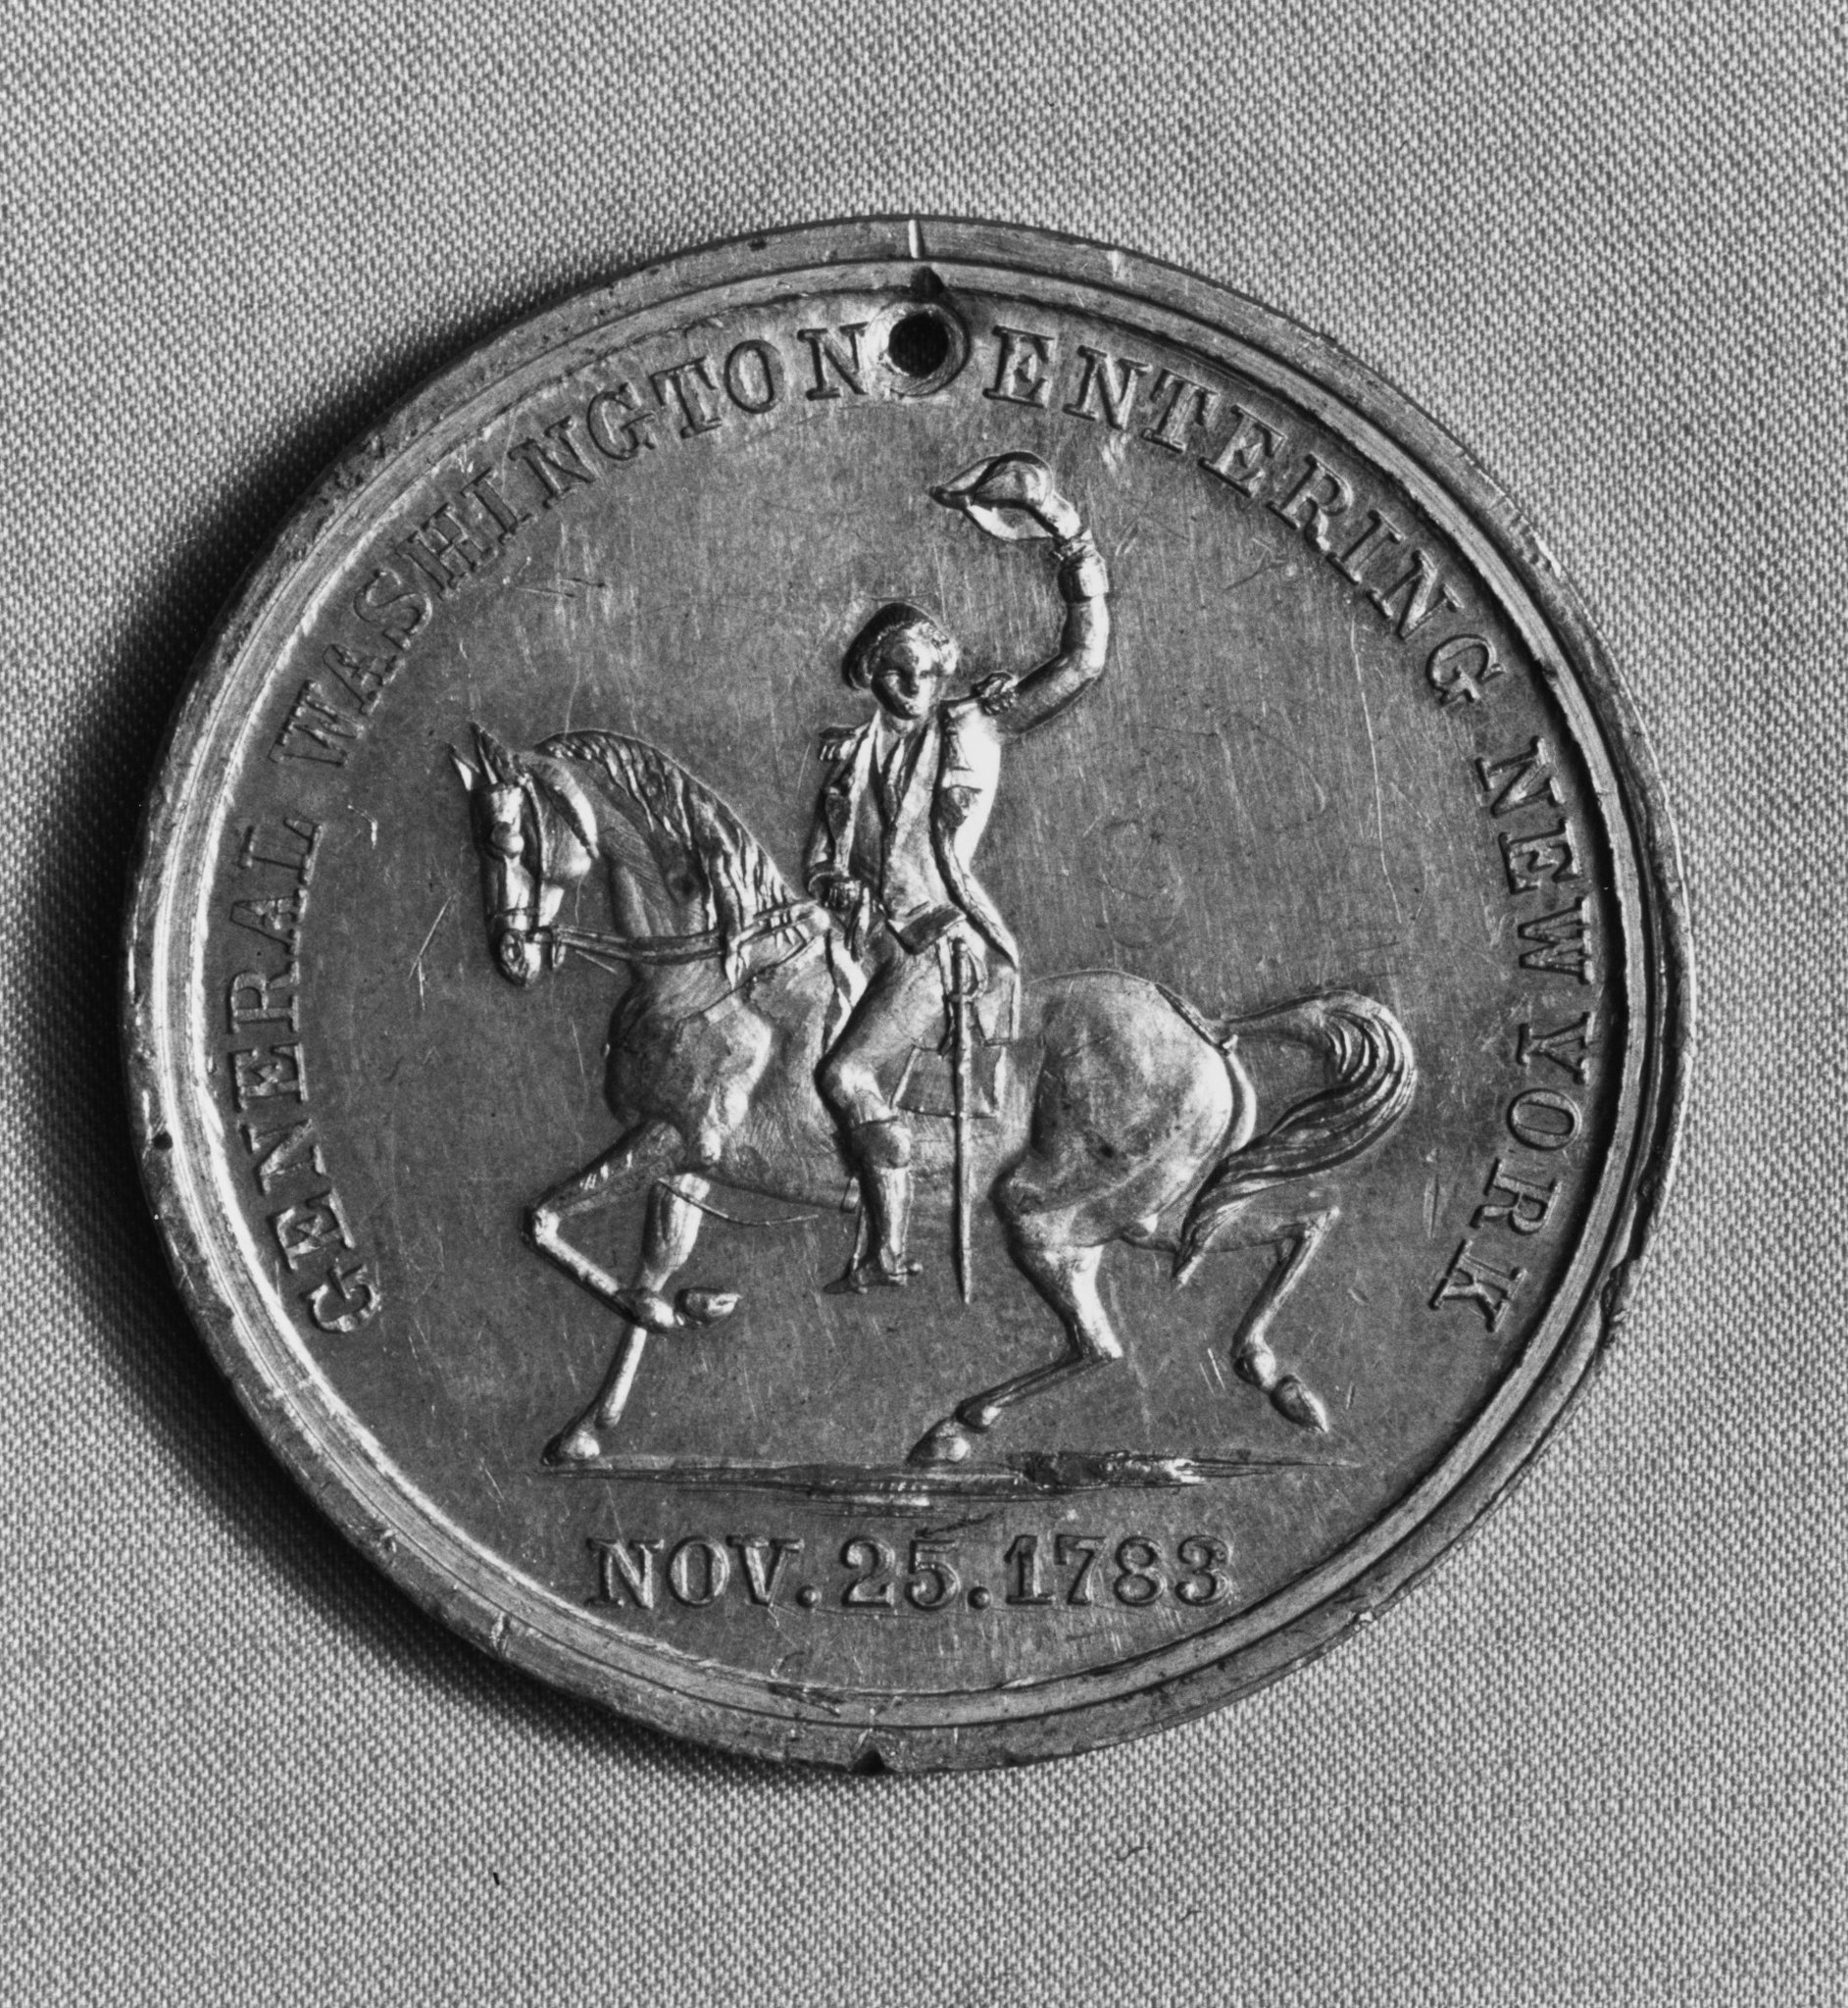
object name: medal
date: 1883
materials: metal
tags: george washington,horses,ships